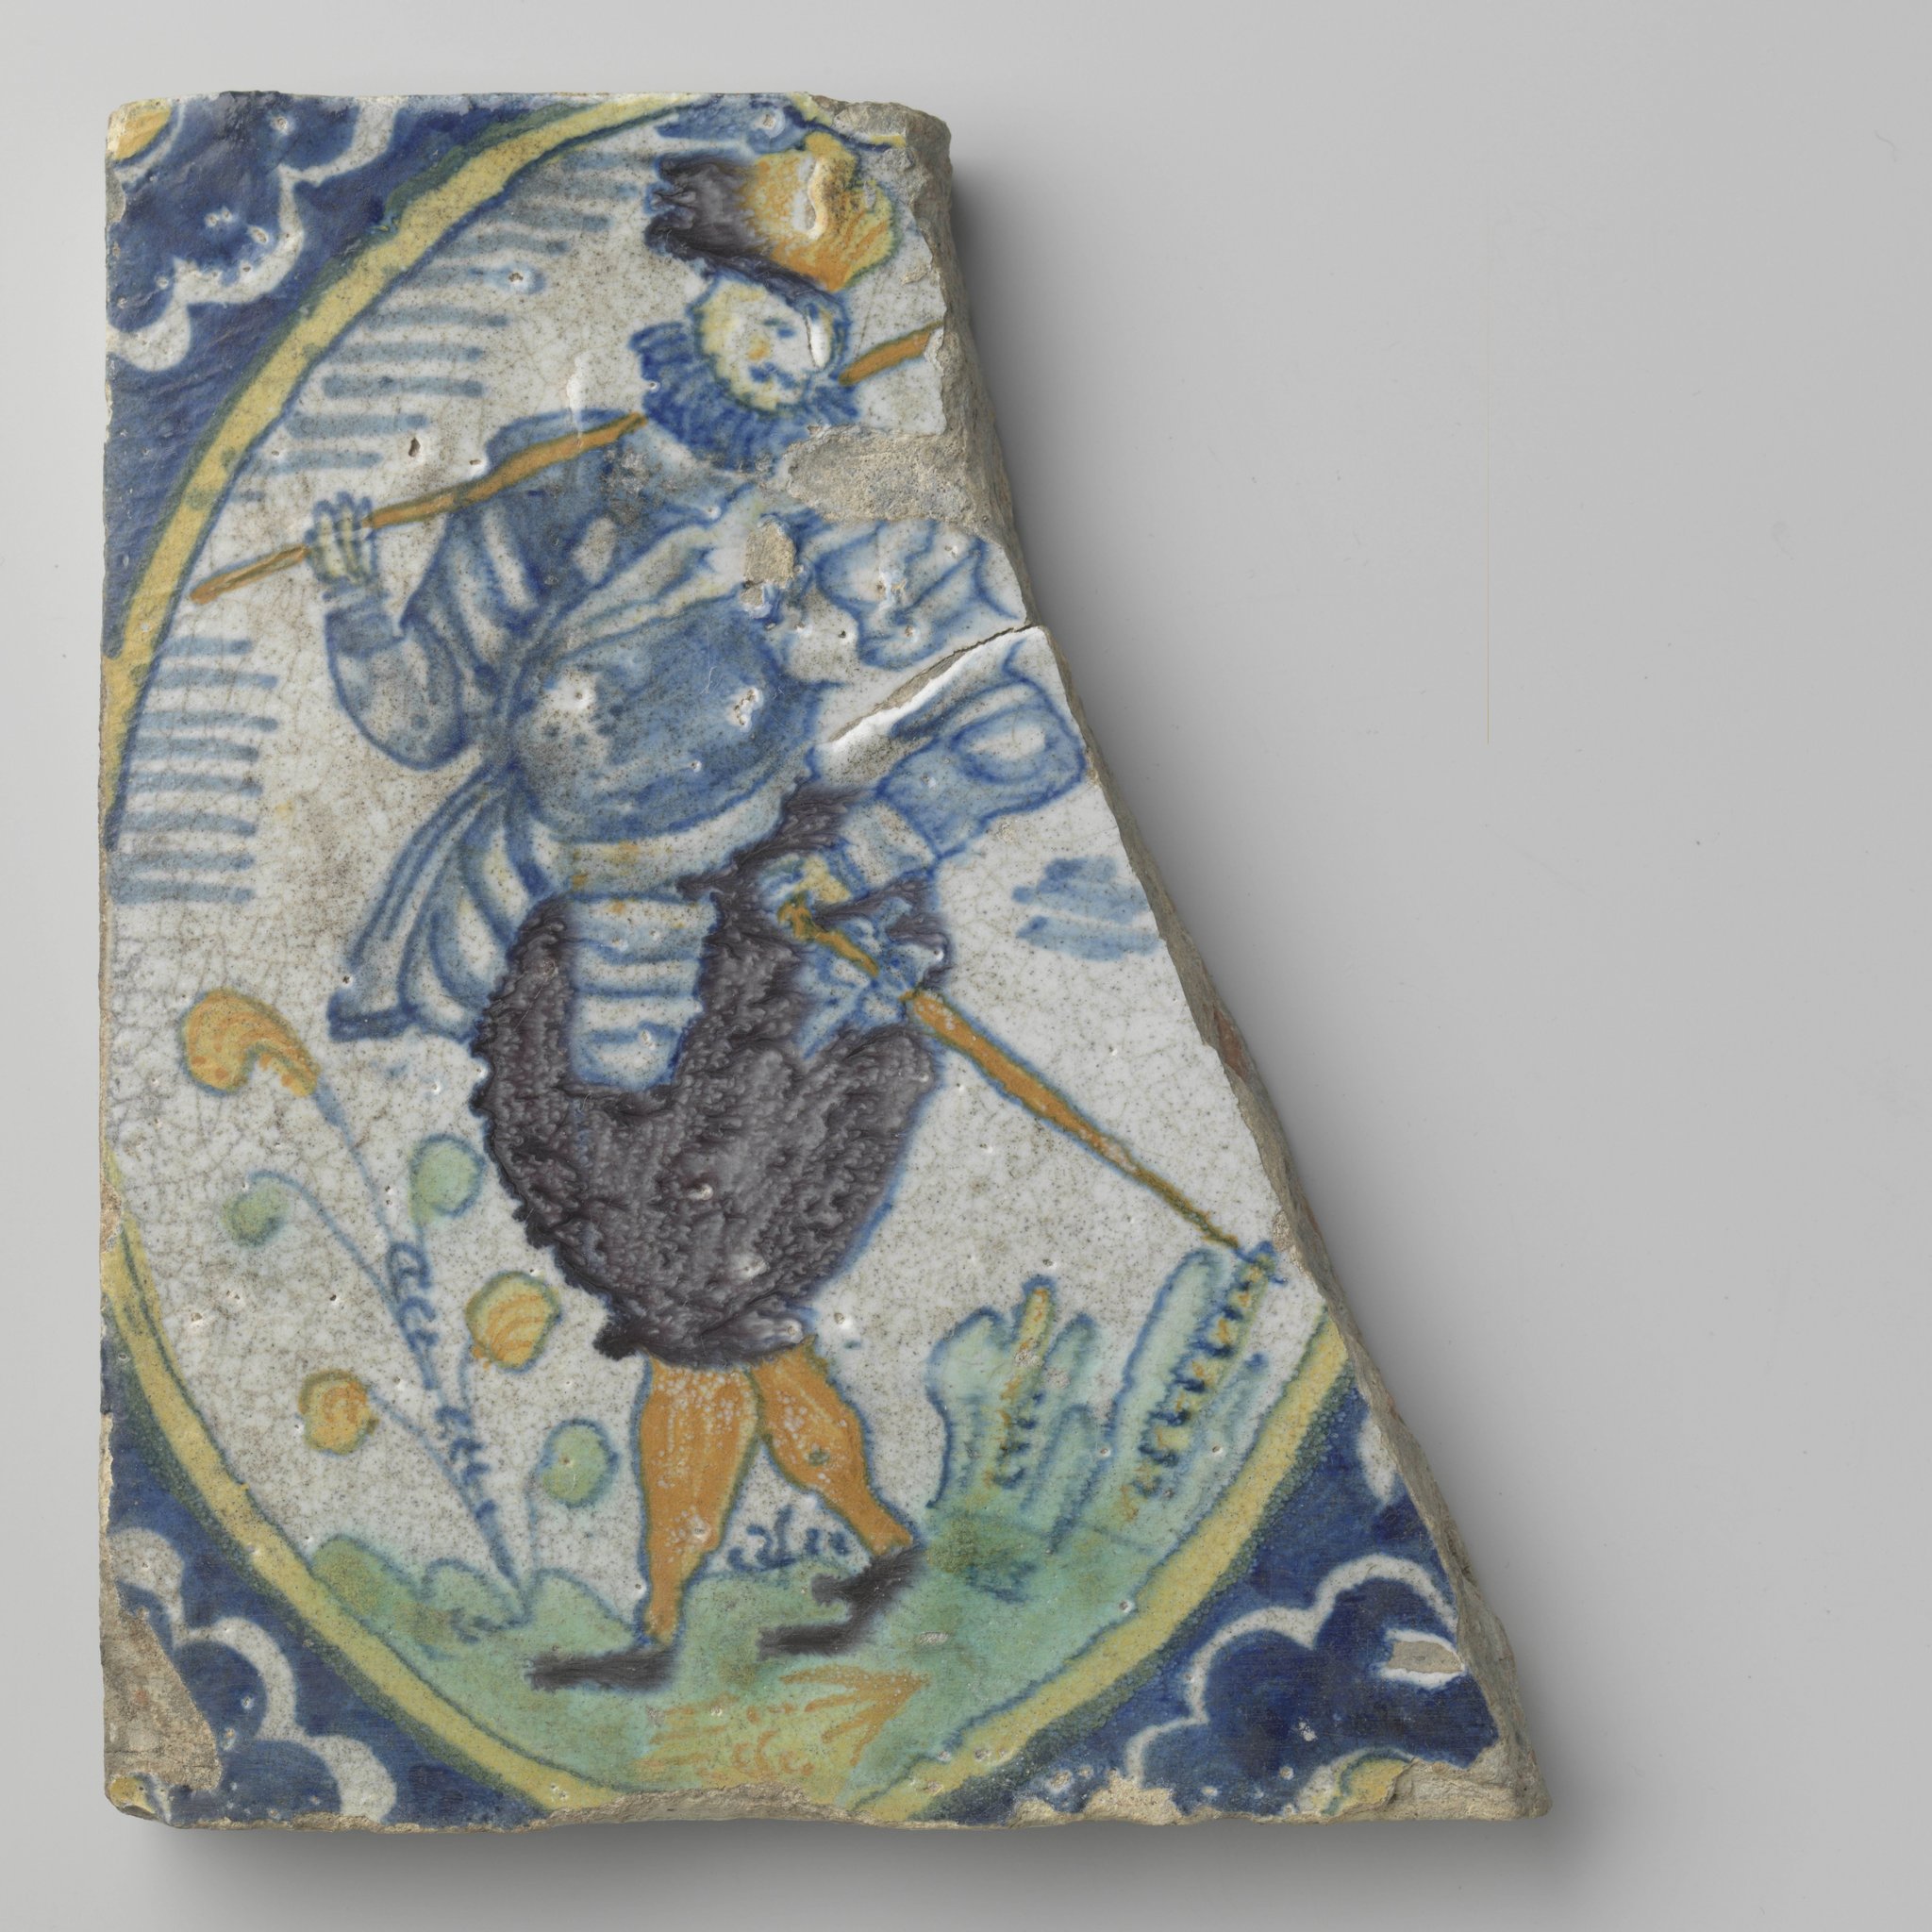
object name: tile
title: Fragment van een tegel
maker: Anonymous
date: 1580-1625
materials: earthenware, glaze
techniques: maiolica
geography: netherlands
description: Fragment van een tegel met een veelkleurig (blauw, paars, groen, geel en oranje) geschilderde vaandeldrager op een grondje omlijst door een ovaal. In de hoeken, een blauwe rozet met geel hart in vultechniek.